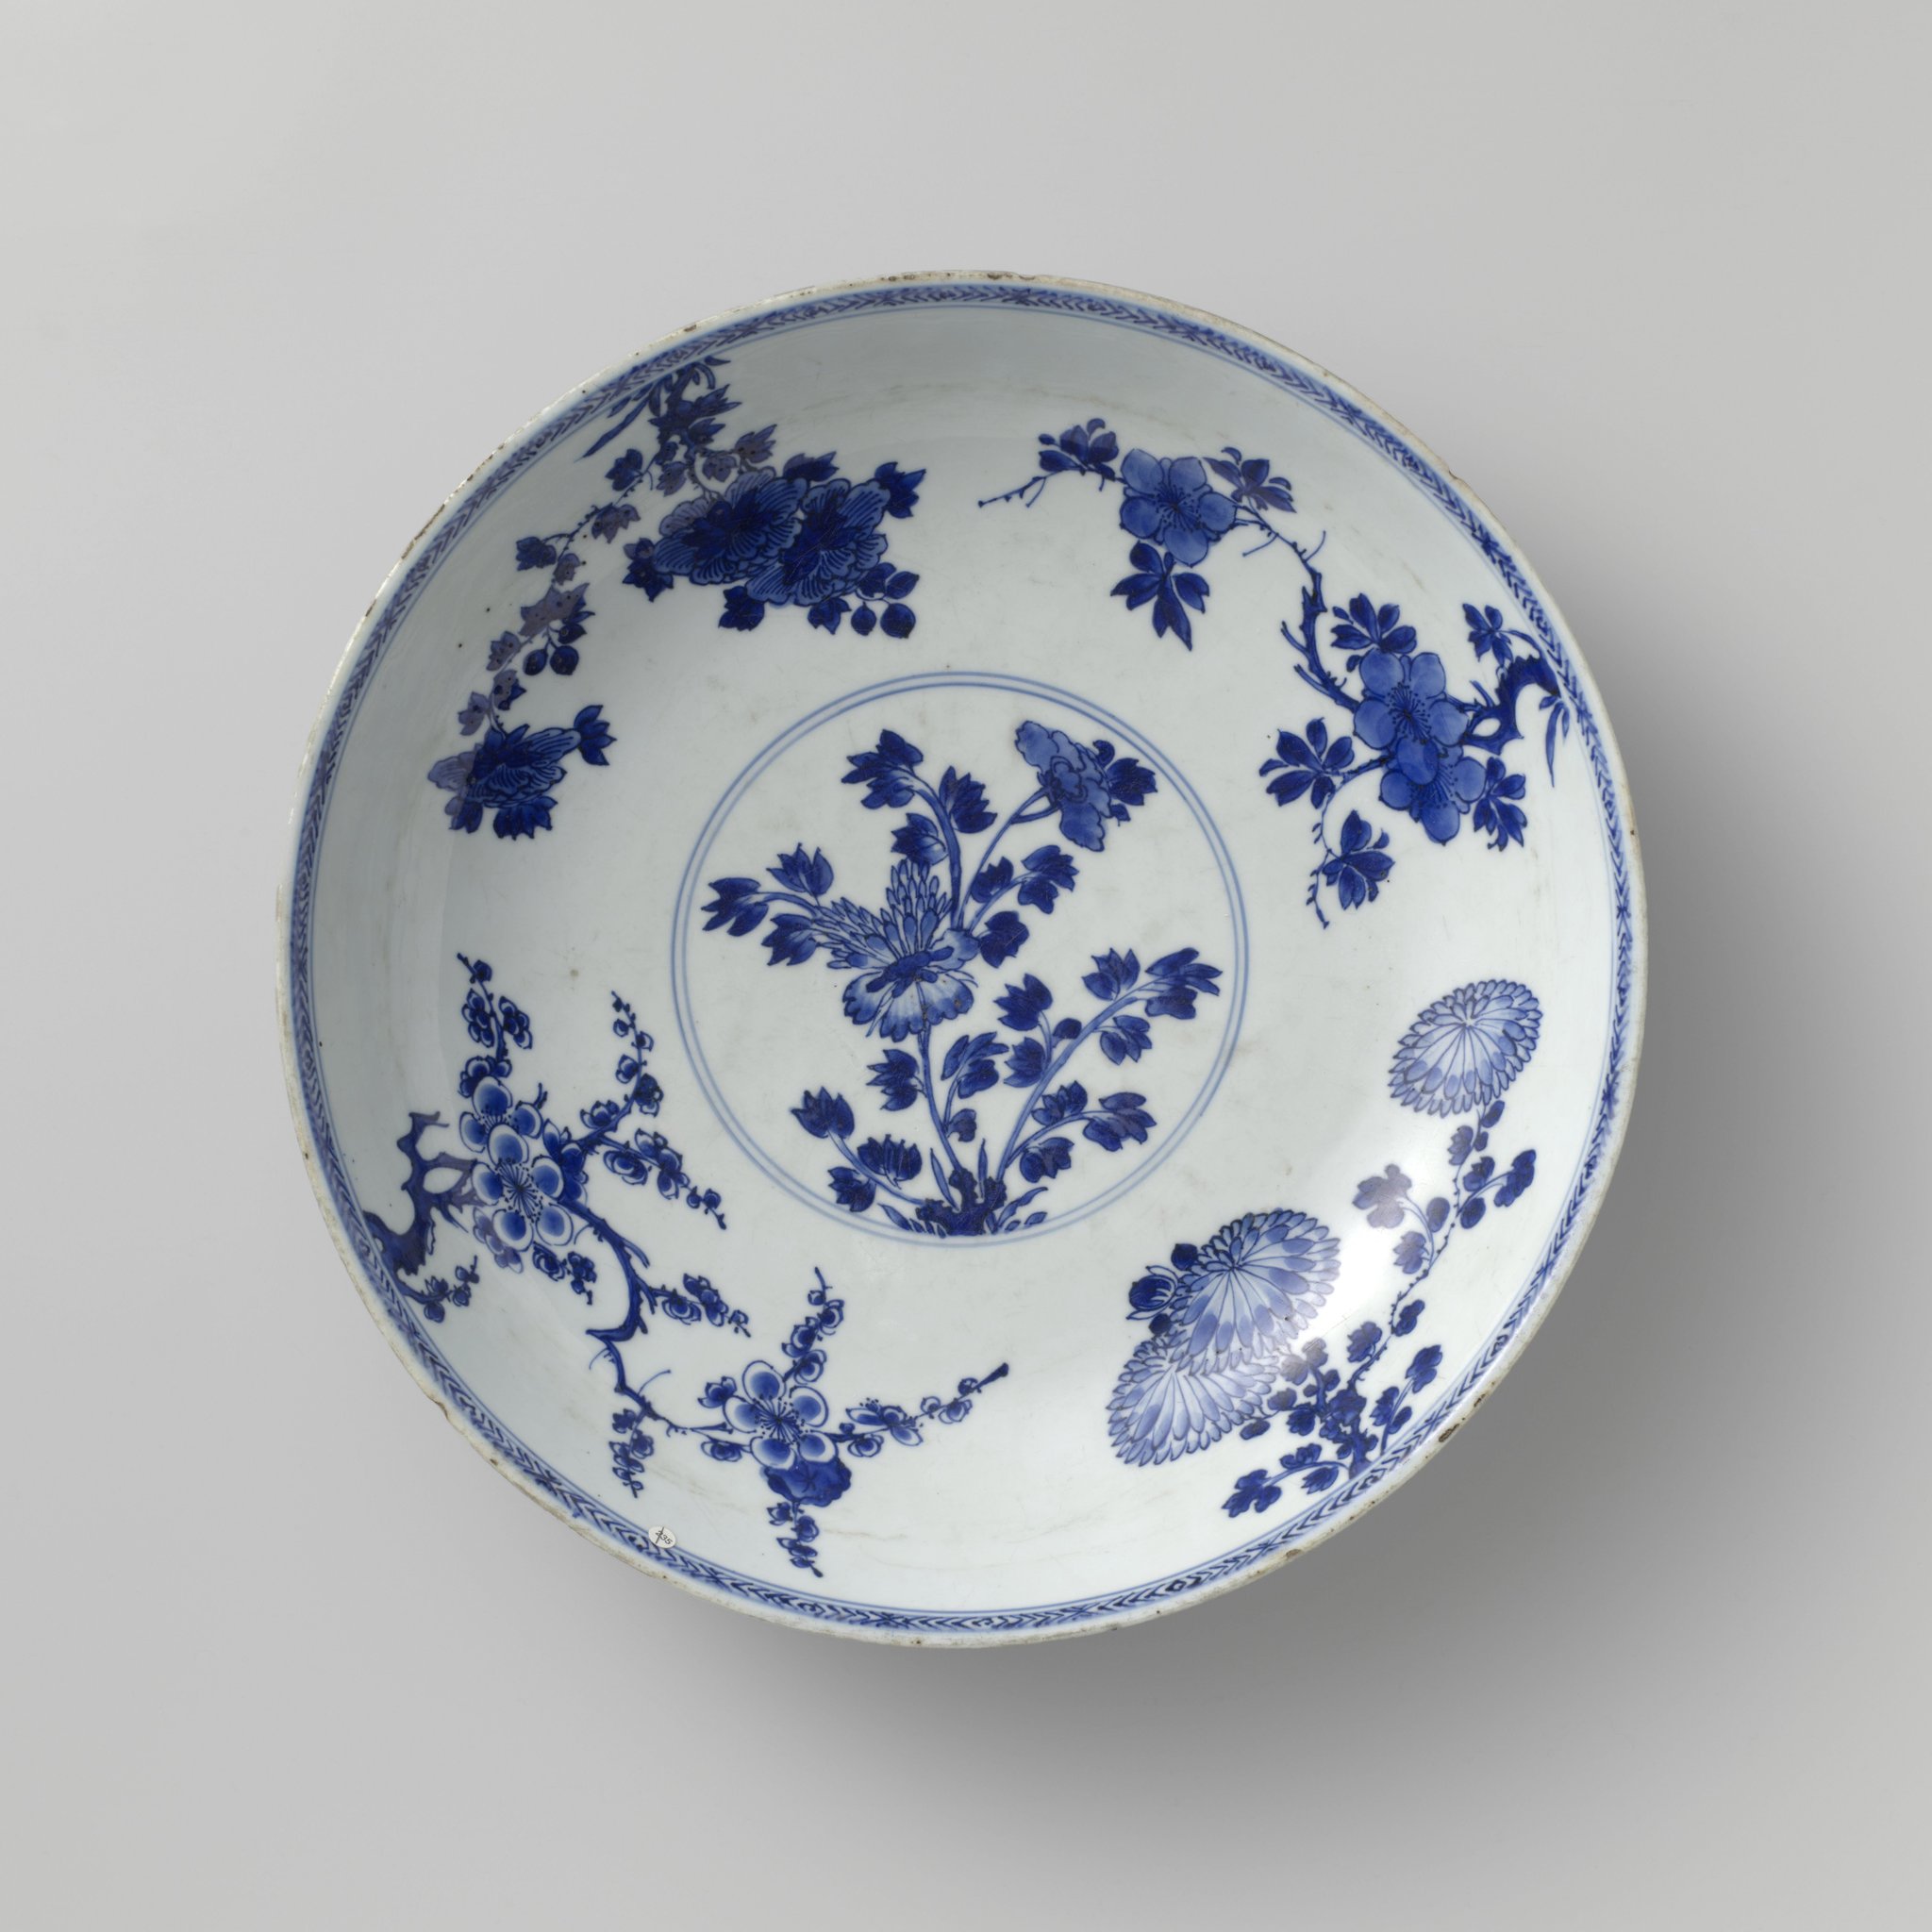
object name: platter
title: Saucer-dish with powder blue, flower sprays, auspicious symbols and precious objects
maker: Anonymous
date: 1700-1724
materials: cobalt, glaze, paint, porcelain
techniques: firing, turning, vitrification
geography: china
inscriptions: mark: ‘大 明 成 化 年 製 dà míng Chéng huà nián zhì’